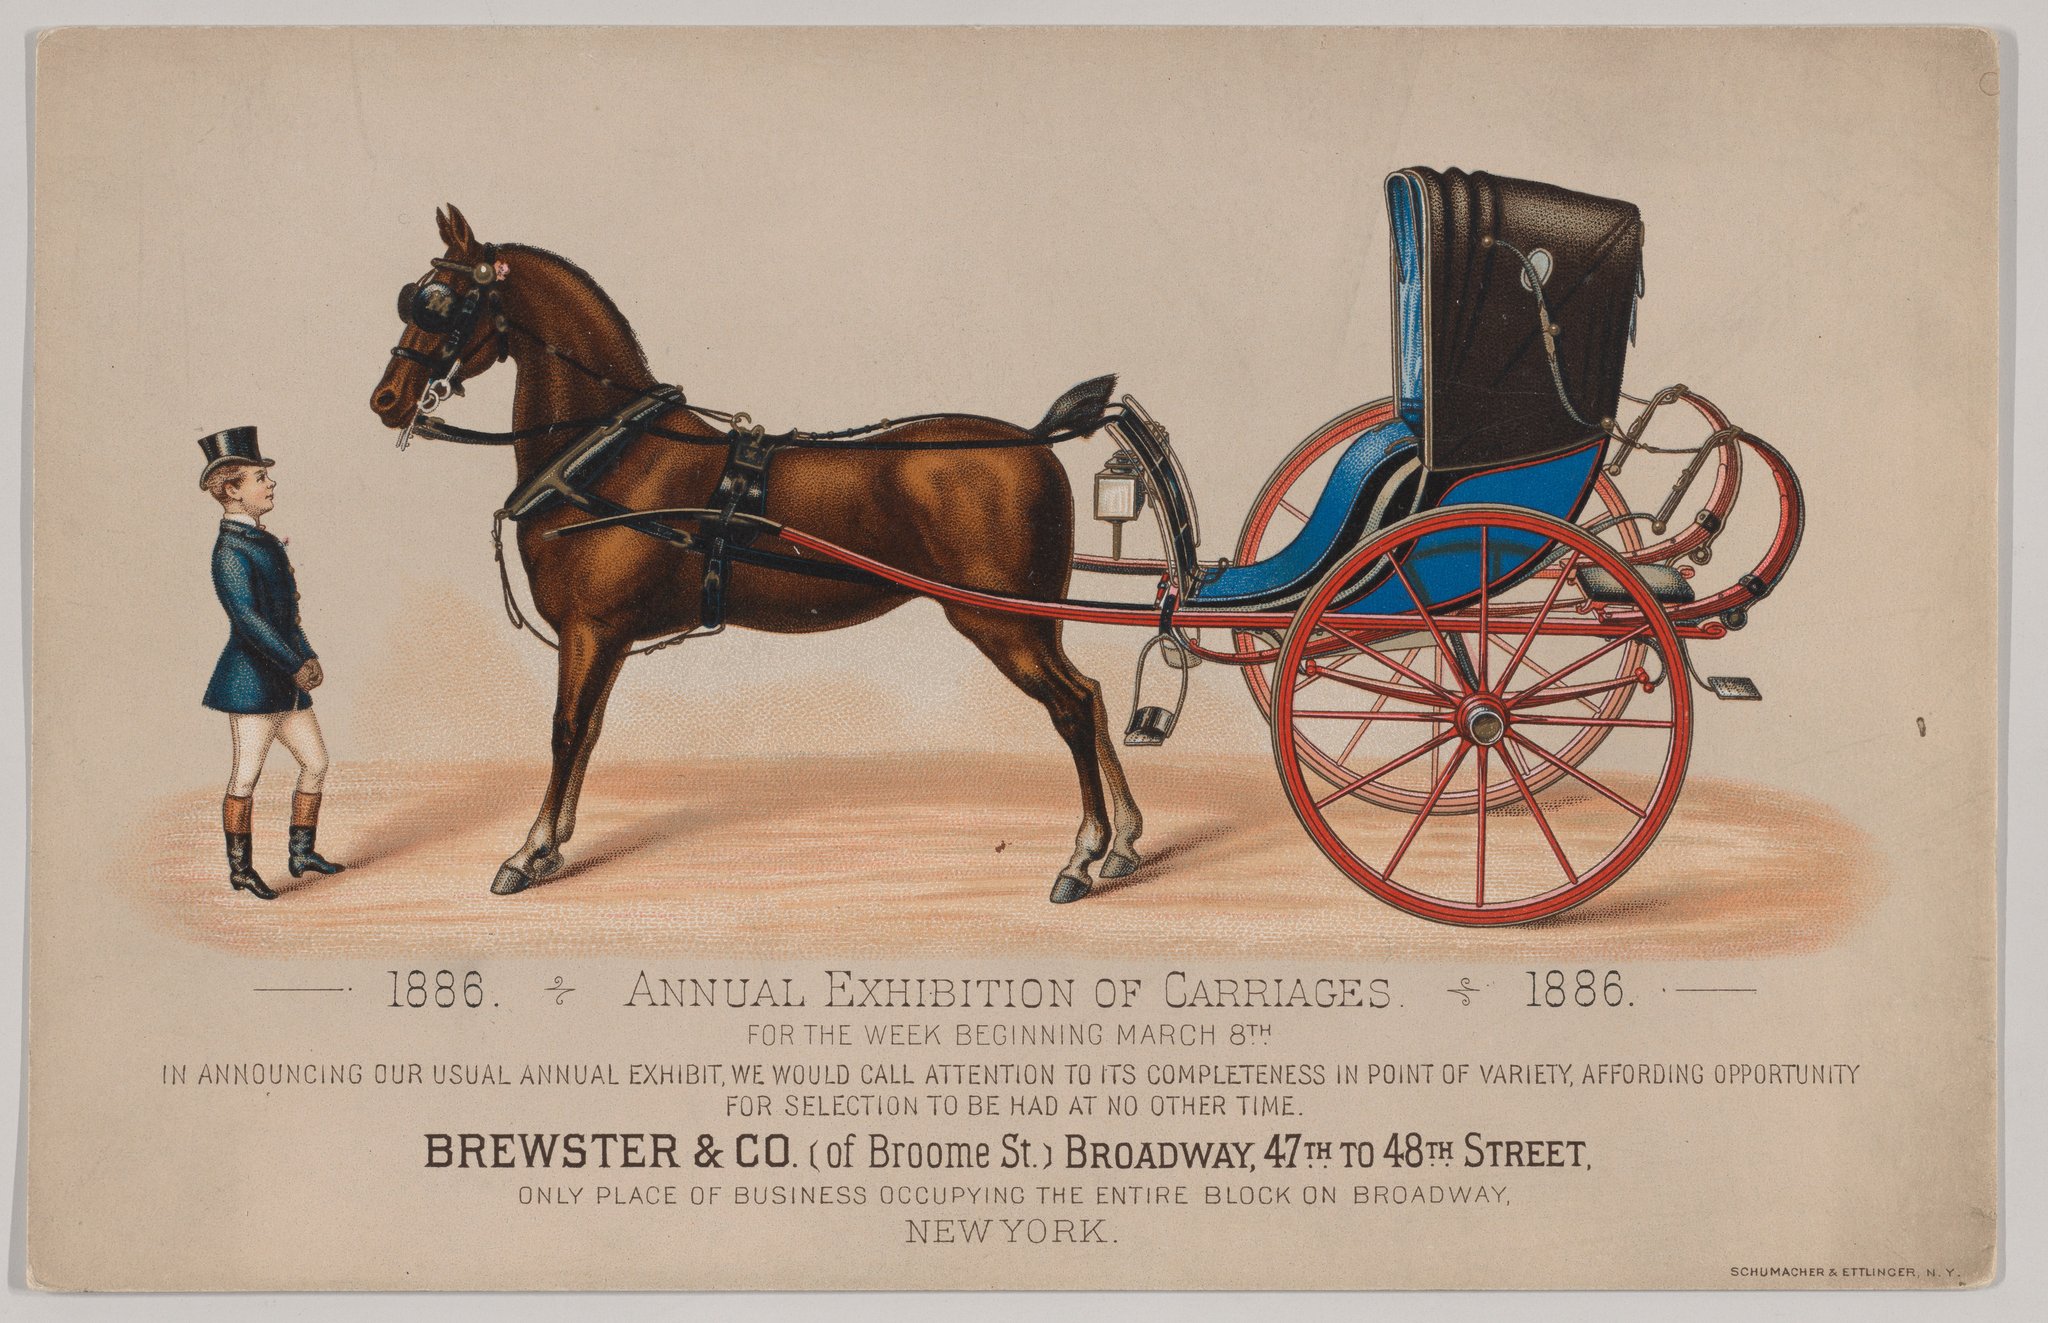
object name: invitation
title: Brewster & Co. Annual Exhibition of Carriages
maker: herman stahmer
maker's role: artist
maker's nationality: american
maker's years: 1857-1894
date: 1886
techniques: lithograph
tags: men,horses,carriages